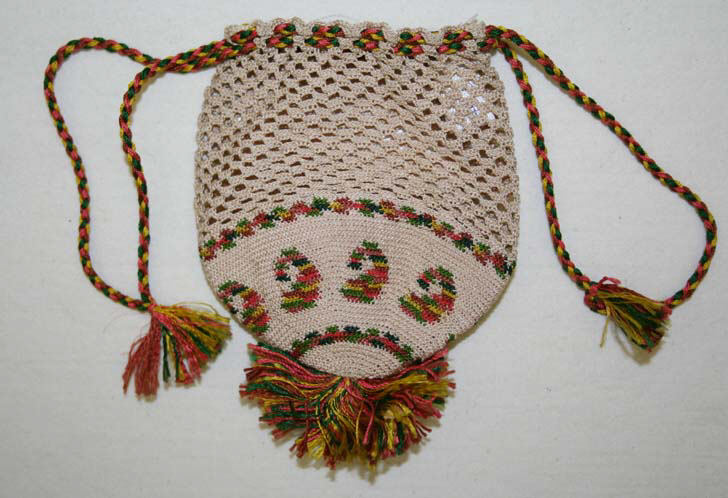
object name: purse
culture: british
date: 1815-1830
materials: cotton, silk